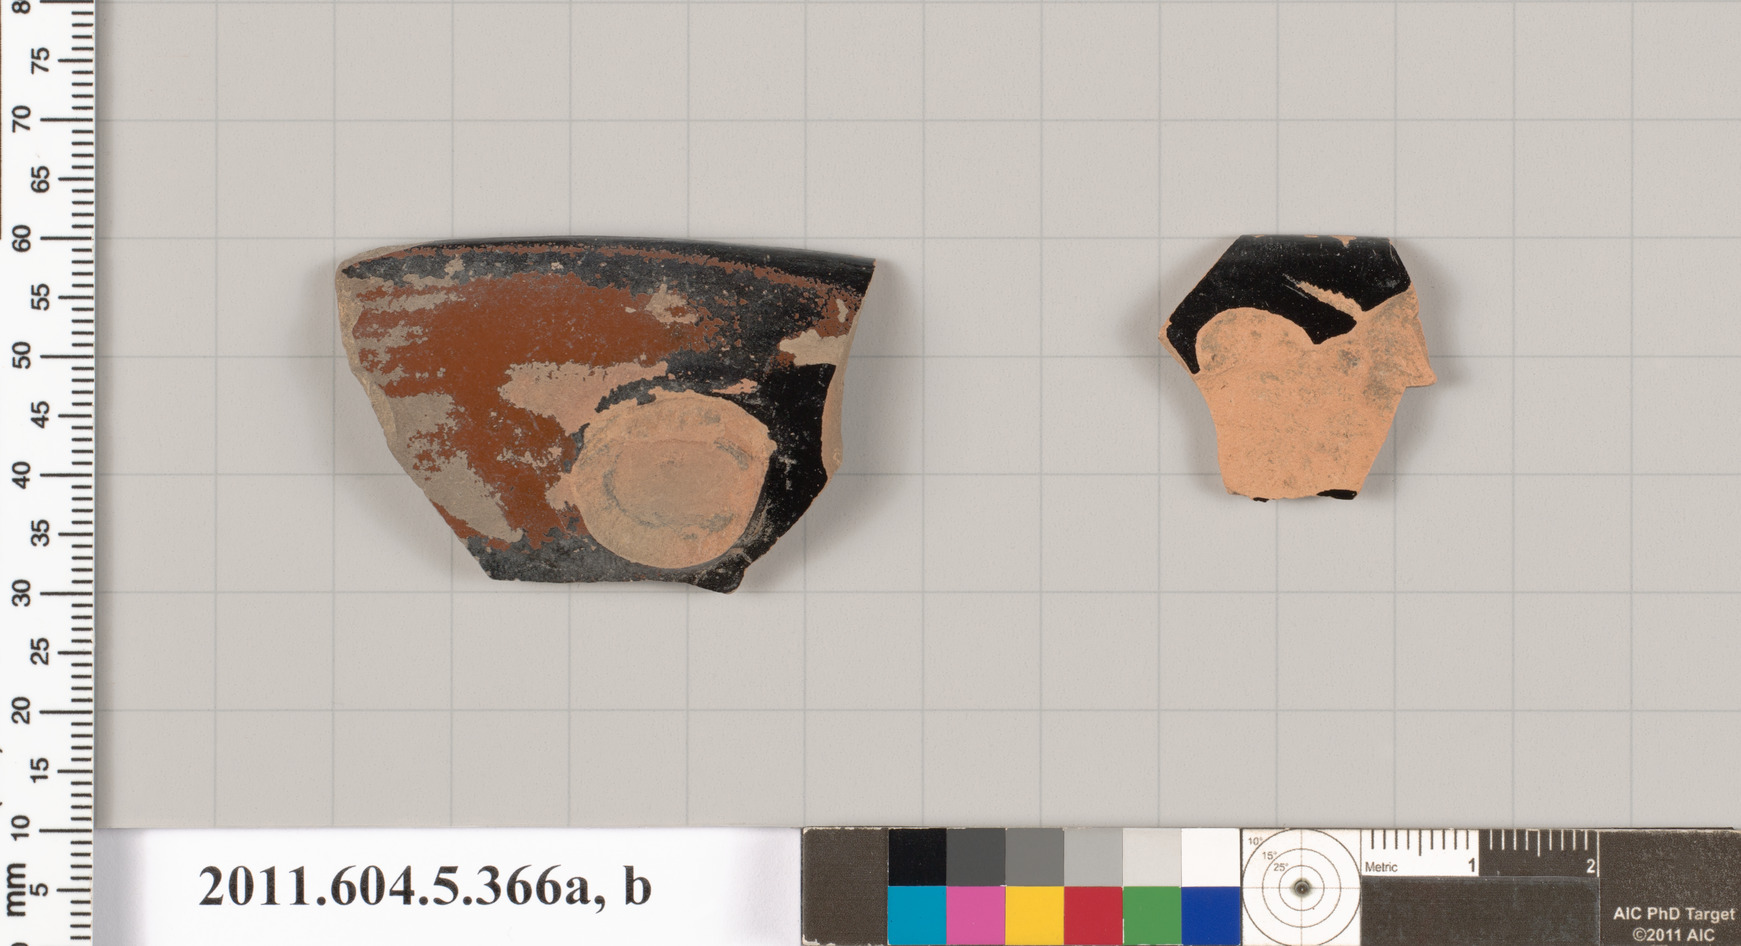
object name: kylix fragment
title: Terracotta rim fragments of kylikes (drinking cups)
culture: greek, attic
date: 600-401 BCE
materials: terracotta